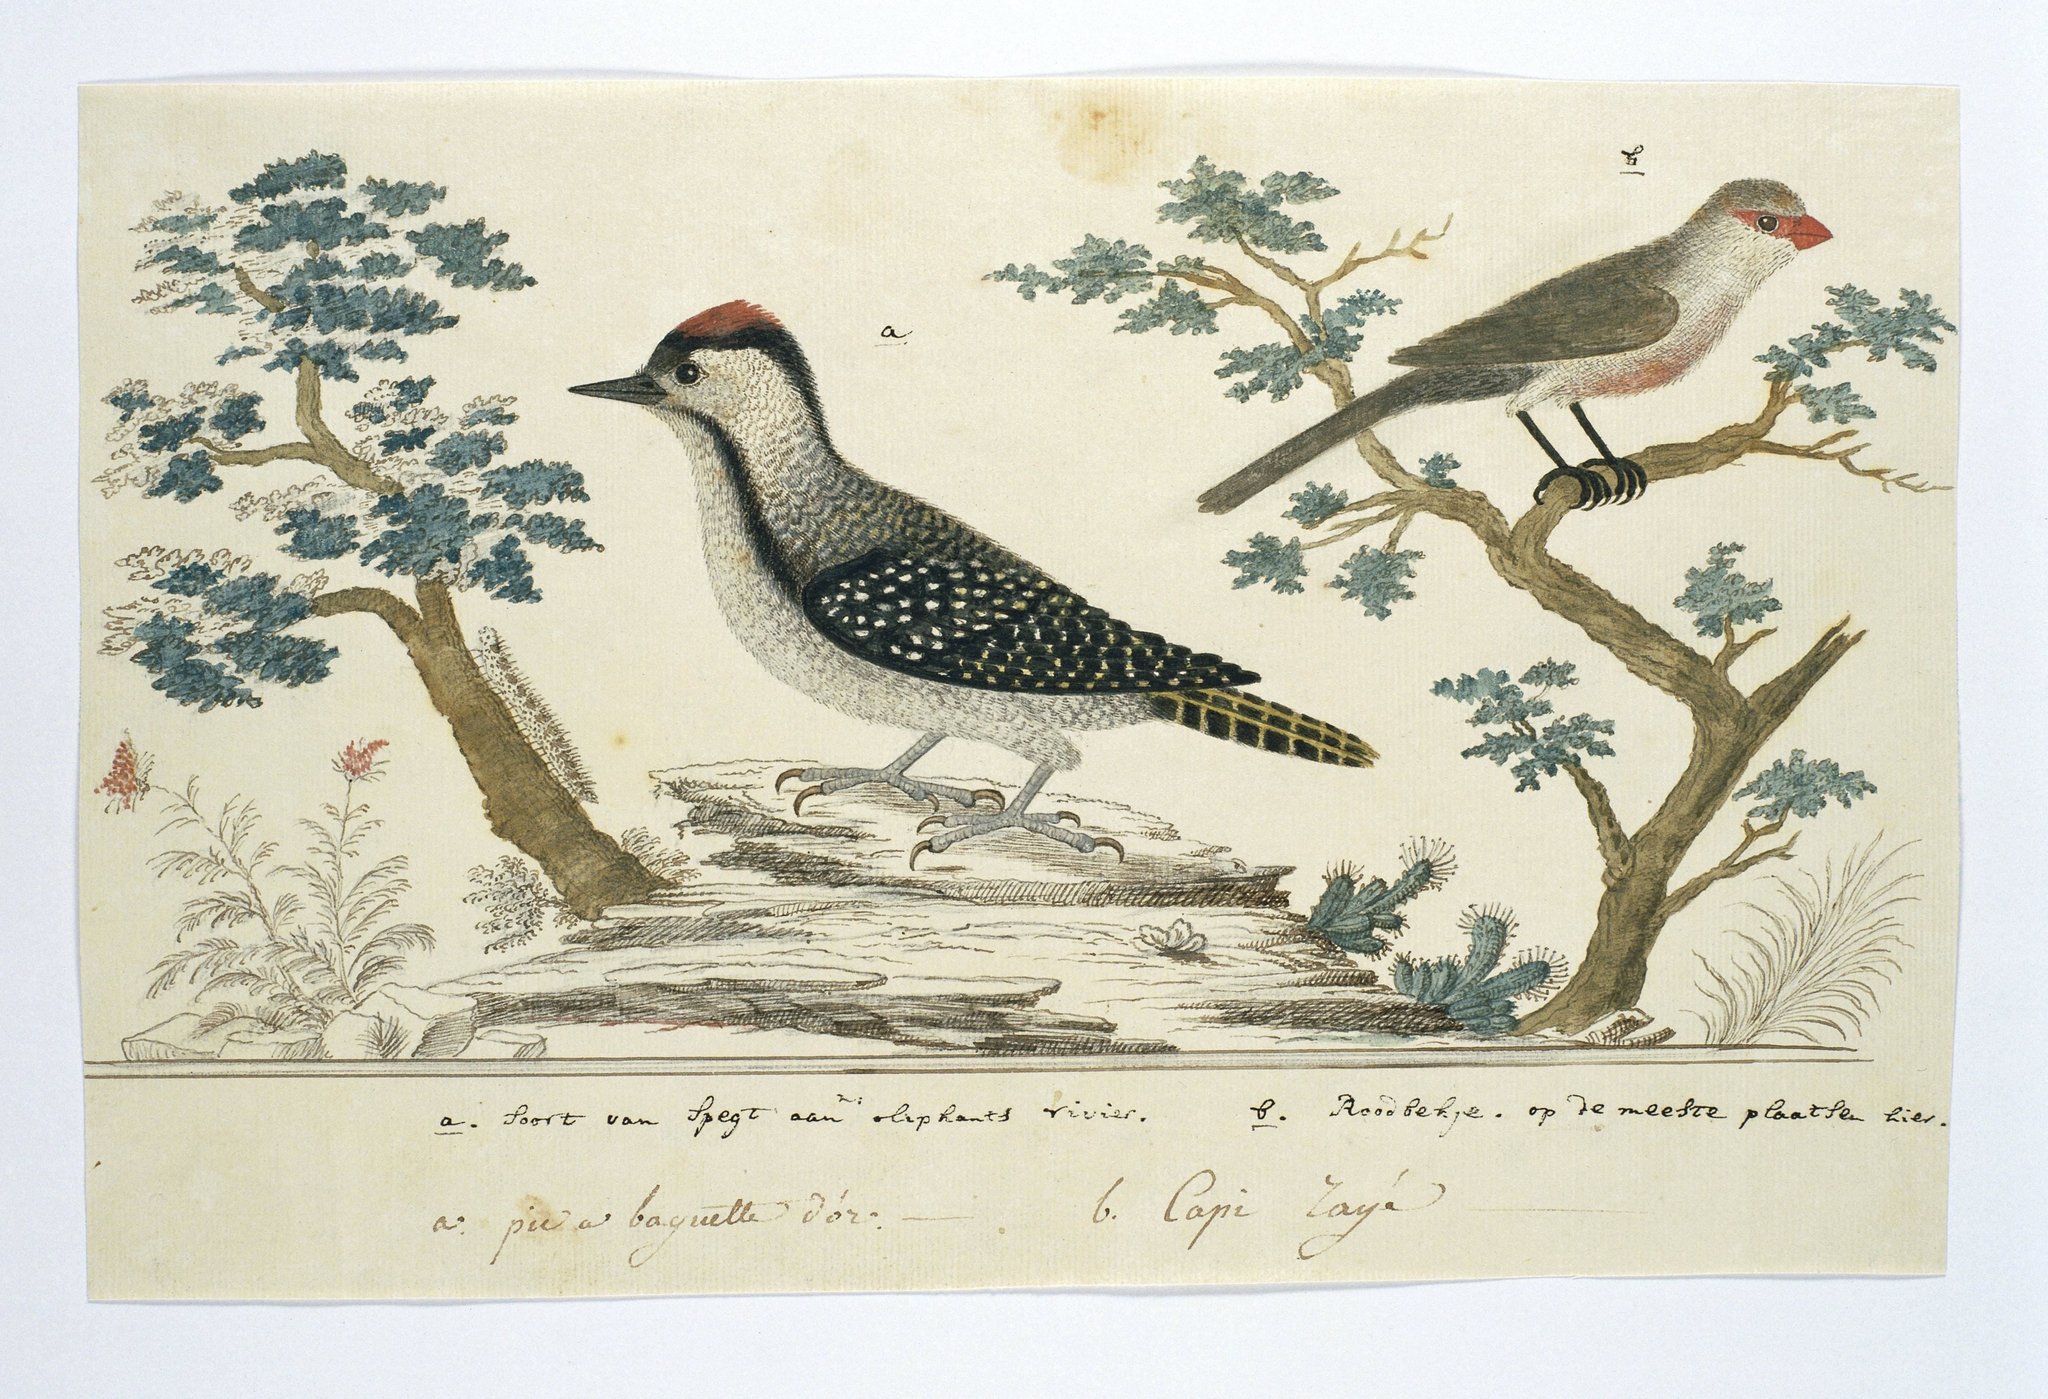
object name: album leaf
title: Dendropicos fuscescens (Cardinal woodpecker)and Estrilda astrild (Common waxbill)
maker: robert jacob gordon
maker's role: draughtsman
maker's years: 1743-1795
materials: chalk, ink, paper, pencil, watercolor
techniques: brush, pen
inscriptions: annotation: ‘in voorstelling boven de vogels "a" en "b" [onderstreept]; in marge: a. soort van Spegt aan [superscript] z, of n: oliphants rivier;’, annotation: ‘in voorstelling boven de vogels "a"en "b" [onderstreept]; in marge: b. Roodbekje. op de meeste plaatsen hier. / b. Capi Rayé’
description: Vogelstudie: links een kardinaalspecht (Dendropicos fuscescens) en rechts een St. Helenafazantje (Estrilda astrild). Gordon noemt het fazantje 'roodbekje'.